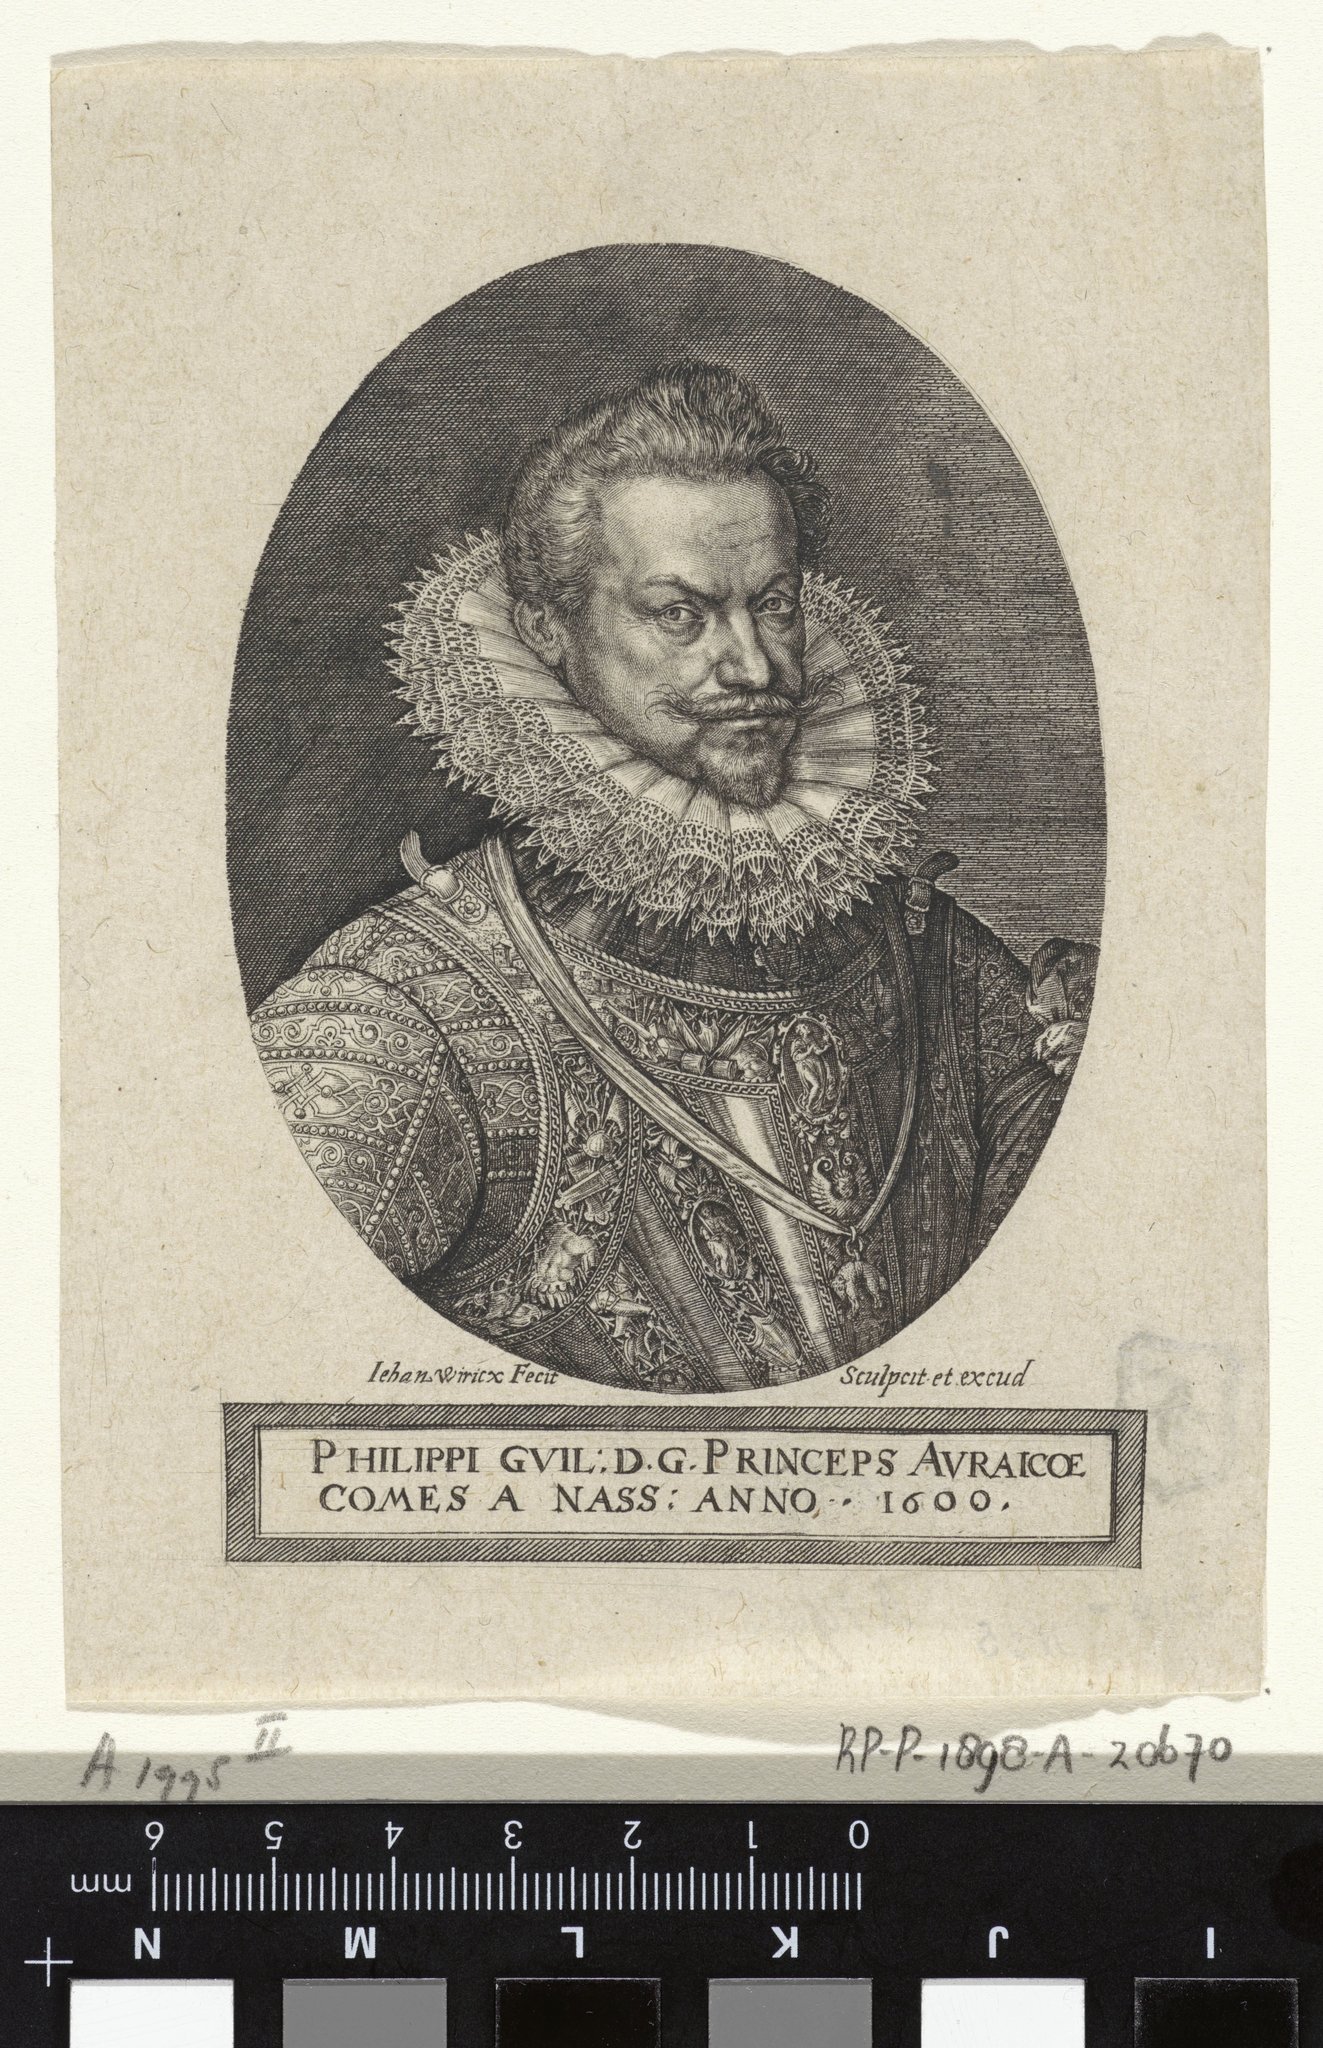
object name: print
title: Portret van Filips Willem, prins van Oranje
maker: johannes wierix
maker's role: draughtsman, print maker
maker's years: 1549-1618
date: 1600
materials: paper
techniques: engraving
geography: antwerp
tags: buren, bruges, filips willem (prins van oranje), neck-gear ~ clothing (with name) (+ men's clothes), armour, knighthood order of the golden fleece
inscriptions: collector's mark: Lugt 2228, collector's mark: Lugt 963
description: Hij draagt een harnas en een lint met de Orde van het Gulden Vlies. In het kader een tweeregelig onderschrift in het Latijn.